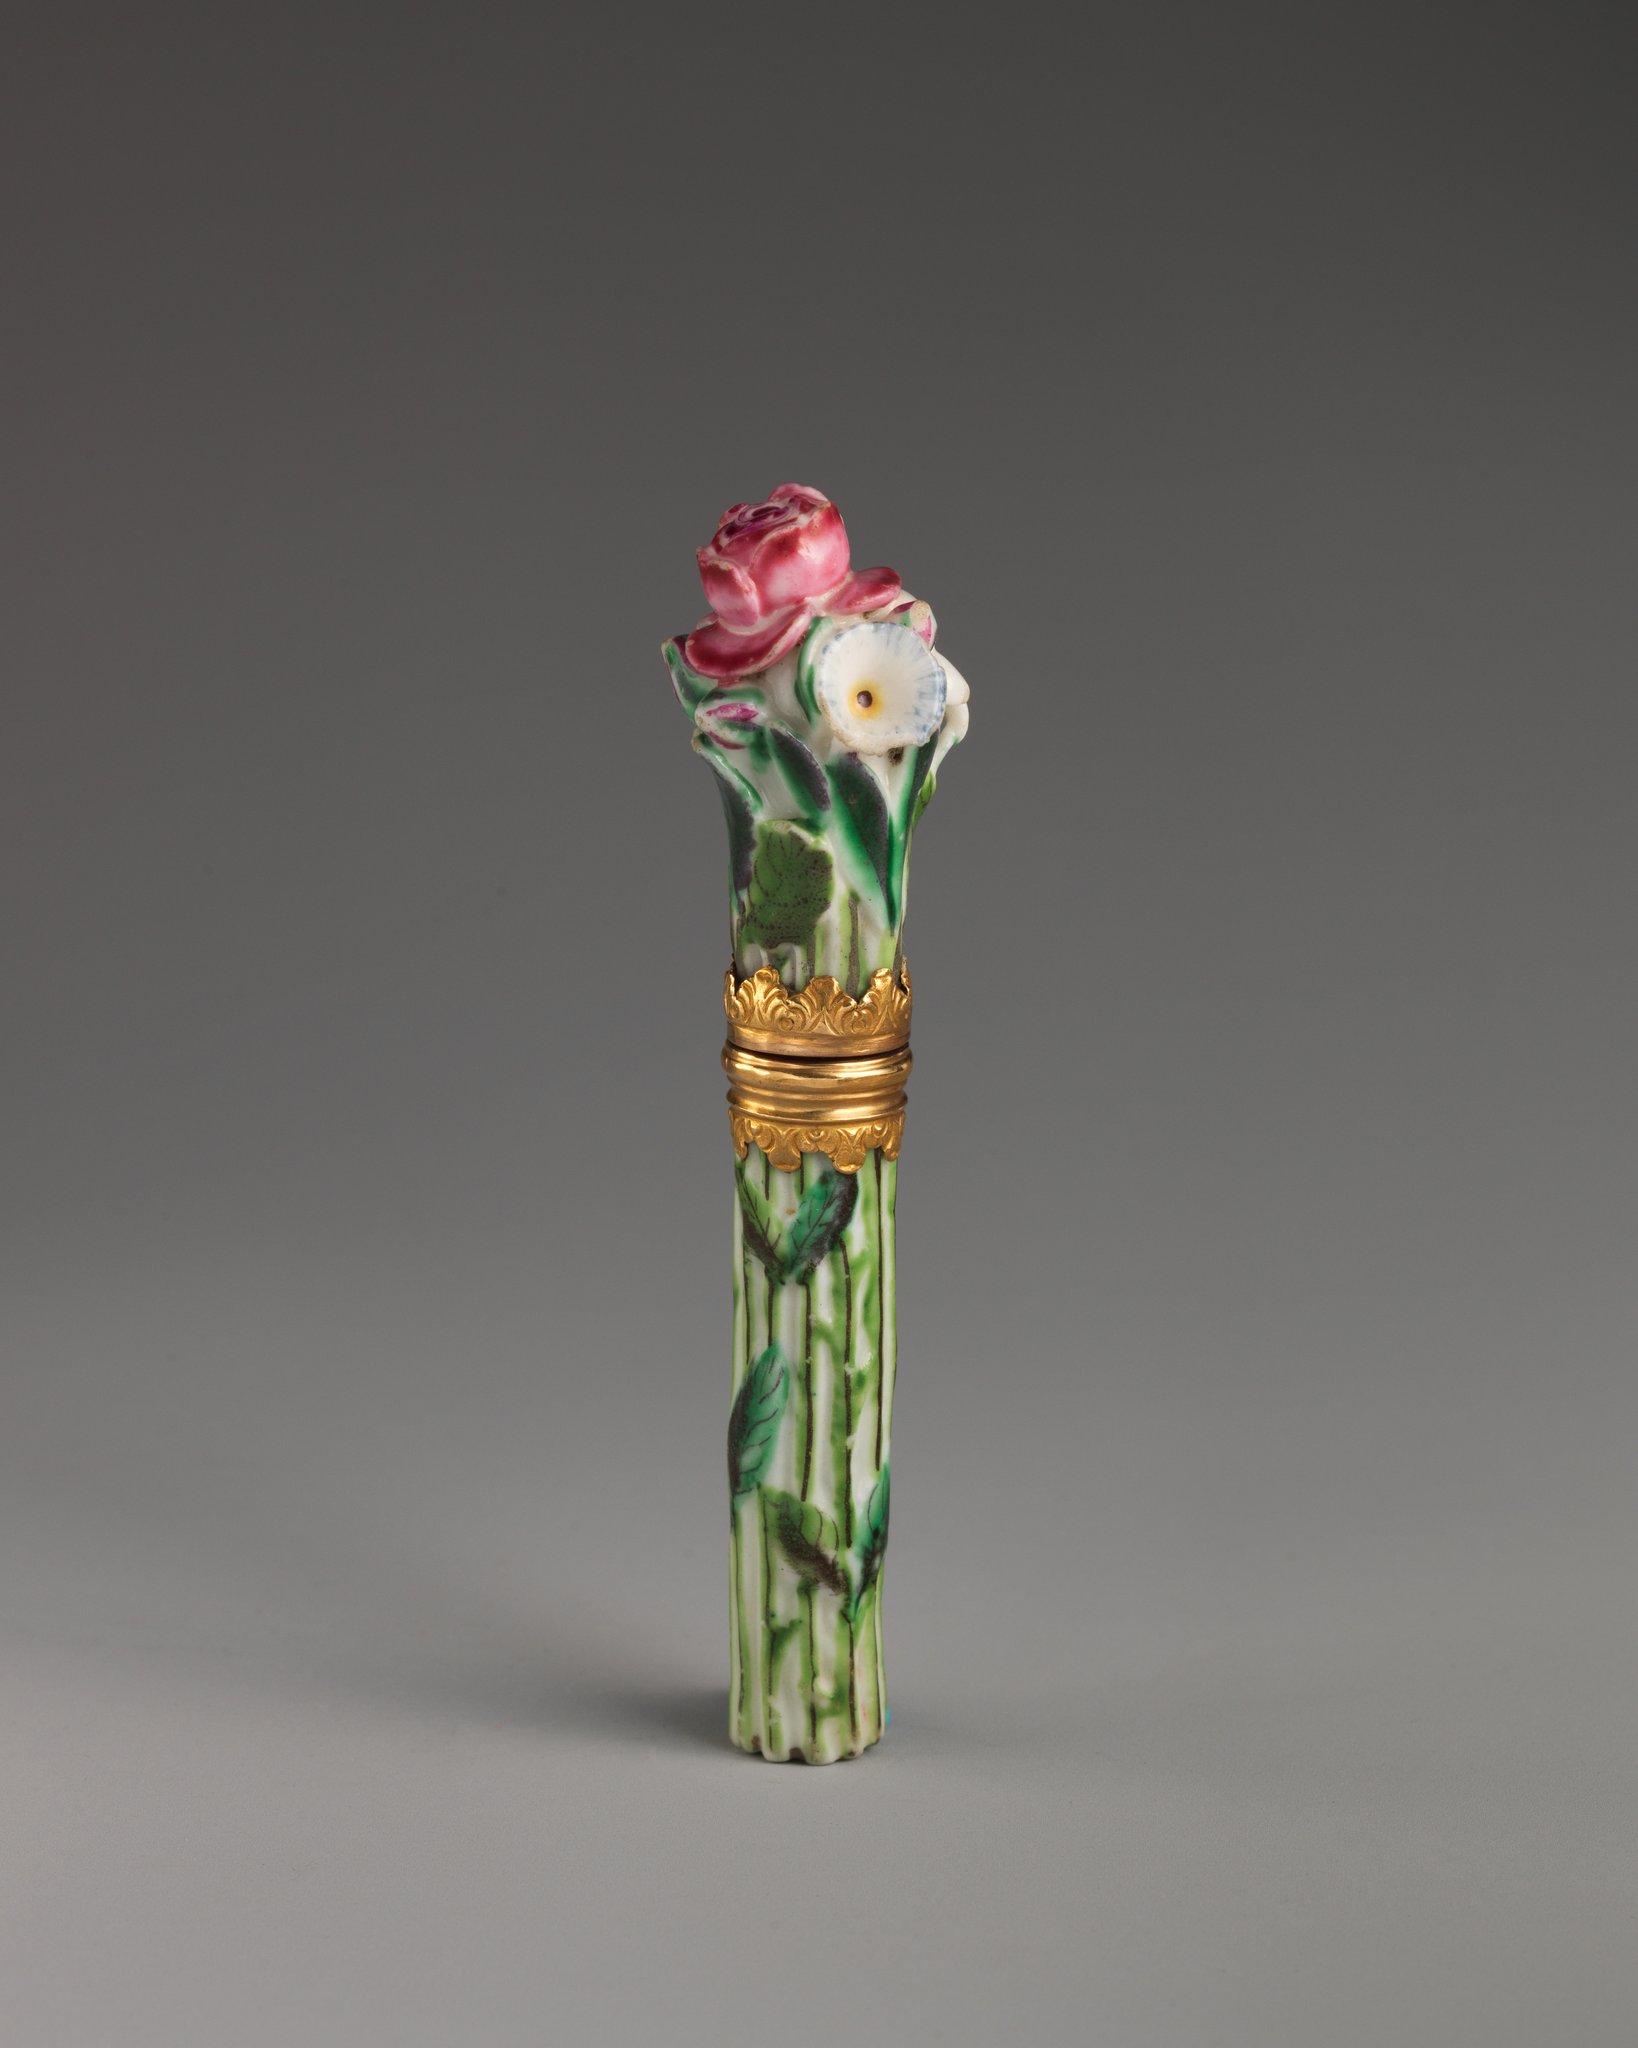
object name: toy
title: Nosegay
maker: saint james's factory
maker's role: maker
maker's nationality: british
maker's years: 1749-1759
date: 1750-1755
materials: soft paste porcelain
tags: flowers